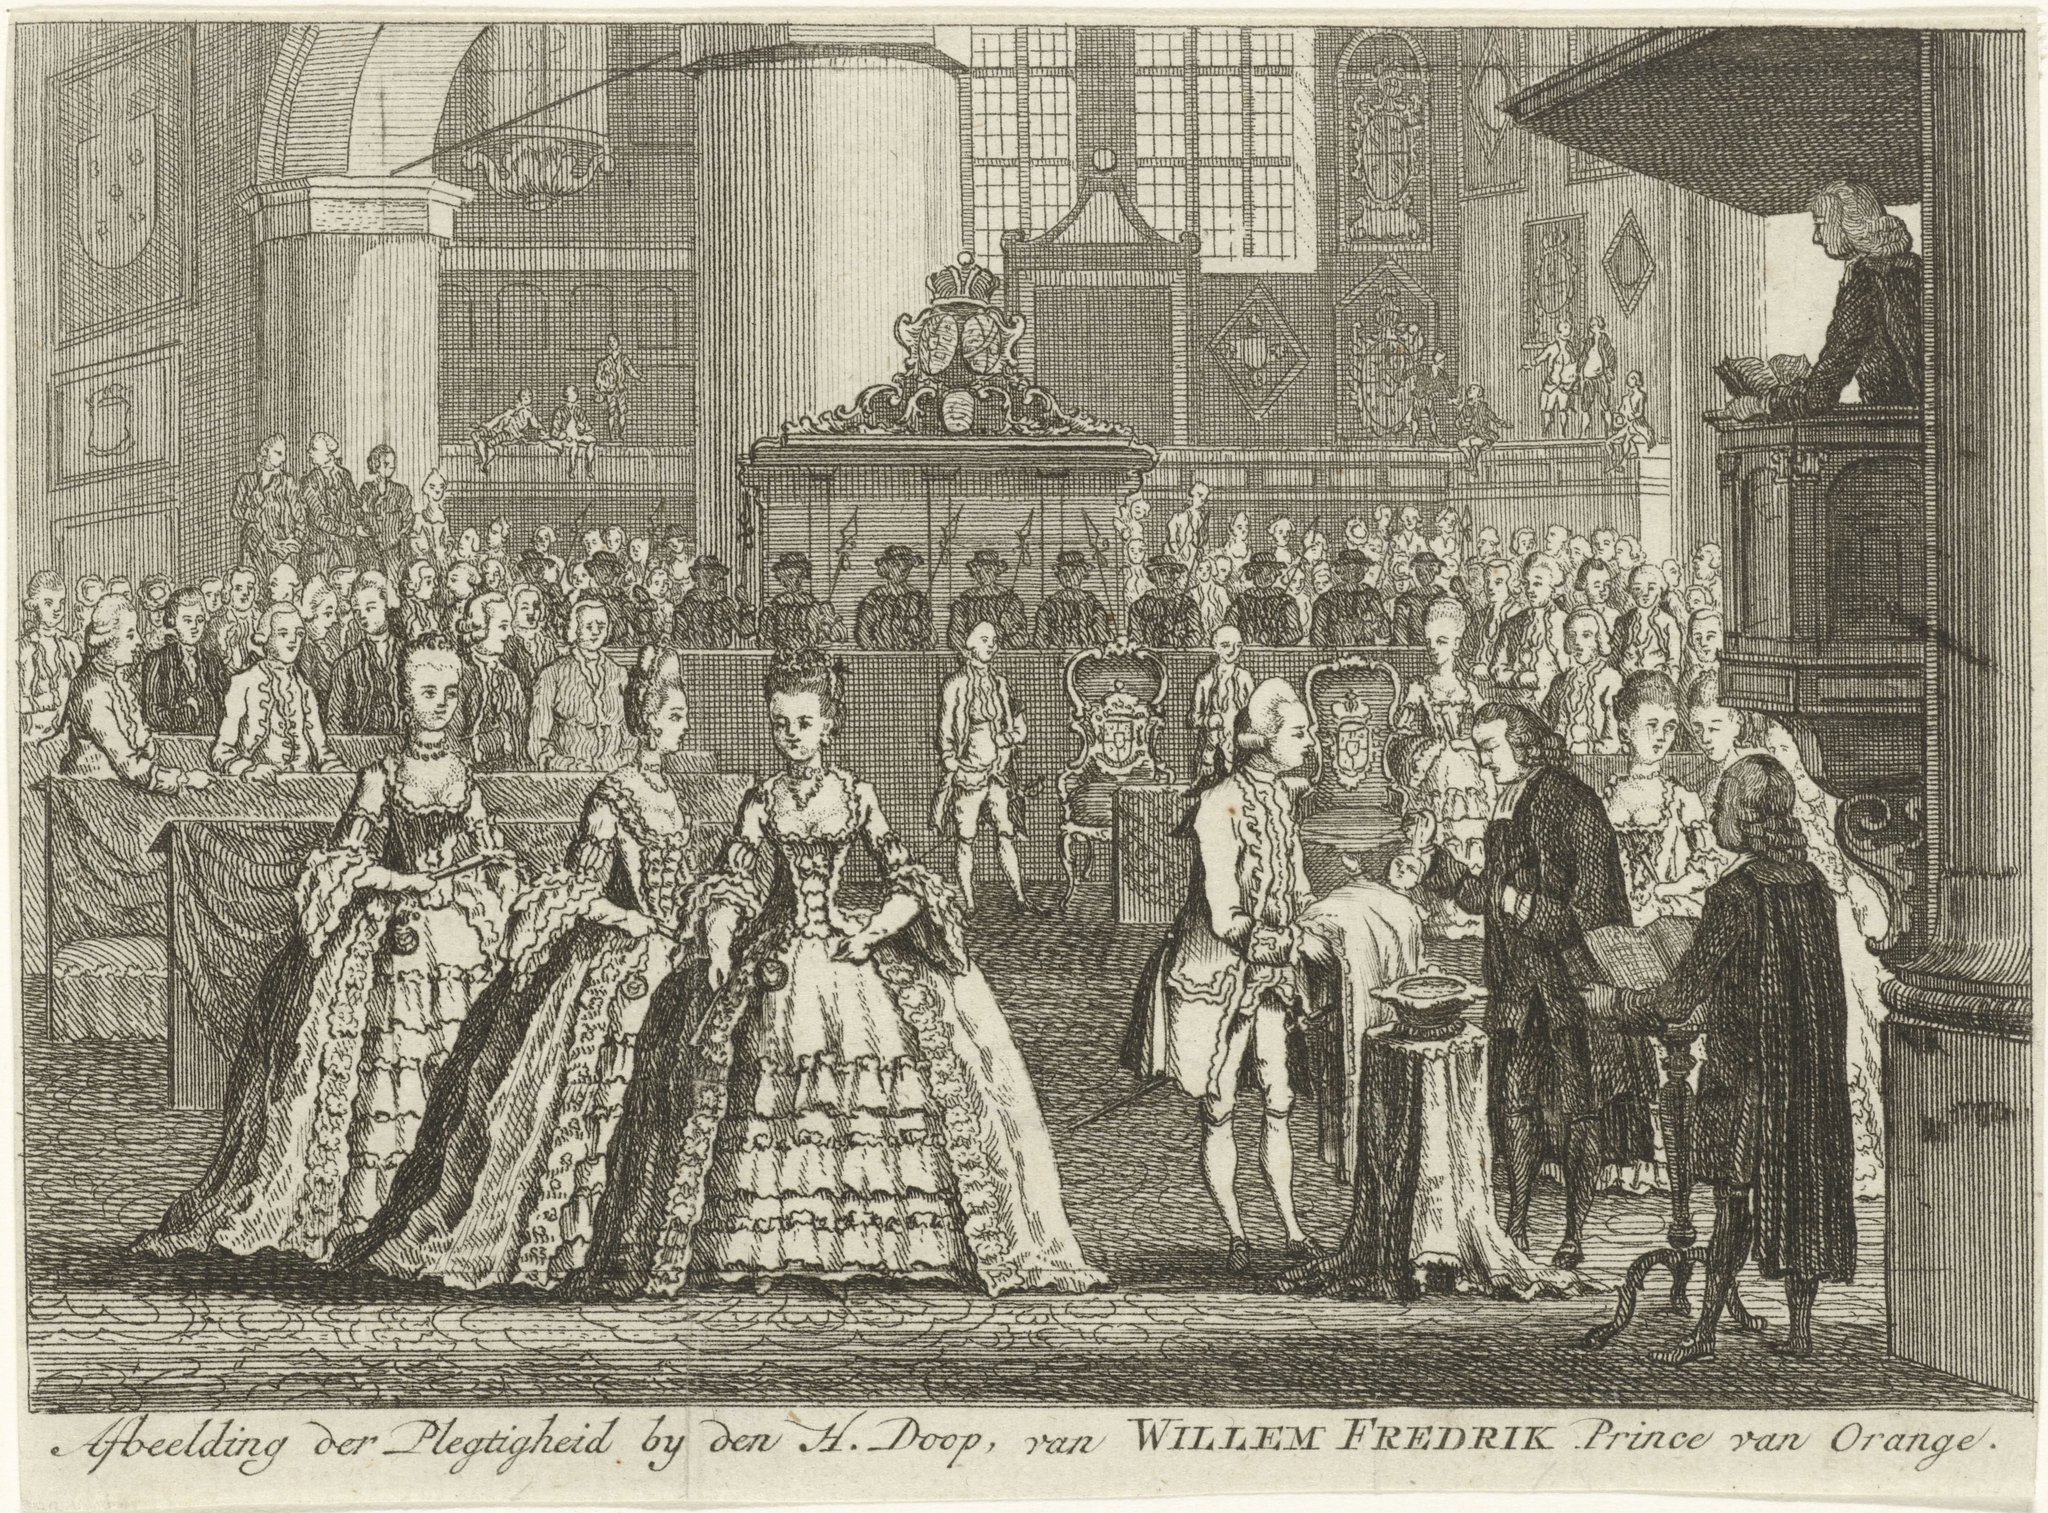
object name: print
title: Afbeelding der Plegtigheid by den H. Doop, van Willem Frederik Prince van Orange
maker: Anonymous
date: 1772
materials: paper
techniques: engraving, etching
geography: northern netherlands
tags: the hague, william v (prince of orange), william i of the netherlands, berlin, painter, draughtsman, wilhelmina of prussia (princess of orange), baptism ~ protestant service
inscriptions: collector's mark: Lugt 2228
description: De doopplechtigheid van prins Willem Frederik, 17 september 1772 in de Grote Kerk te Den Haag. Prins Willem V houdt het kind ten doop, links prinses Wilhelmina van Pruisen met hofdames, rechts predikanten.